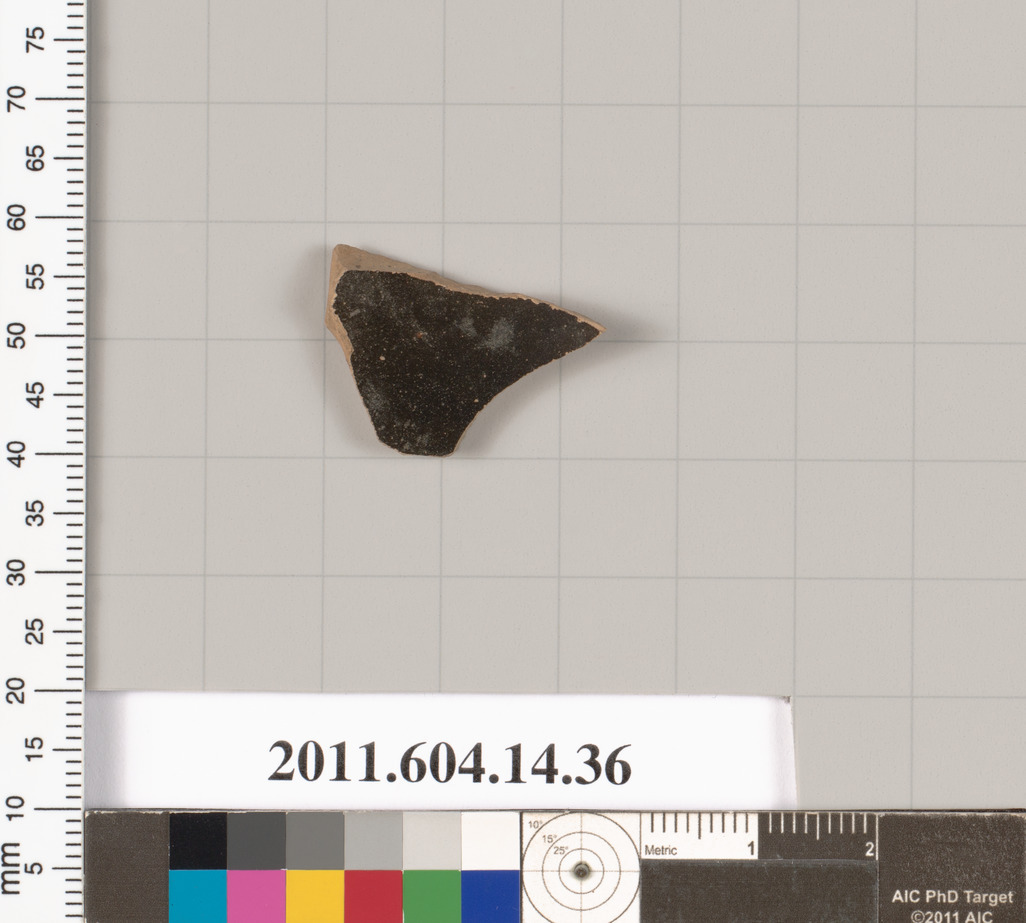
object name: kylix fragment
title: Terracotta fragment of a kylix (drinking cup)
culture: unknown fabric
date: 600-401 BCE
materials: terracotta